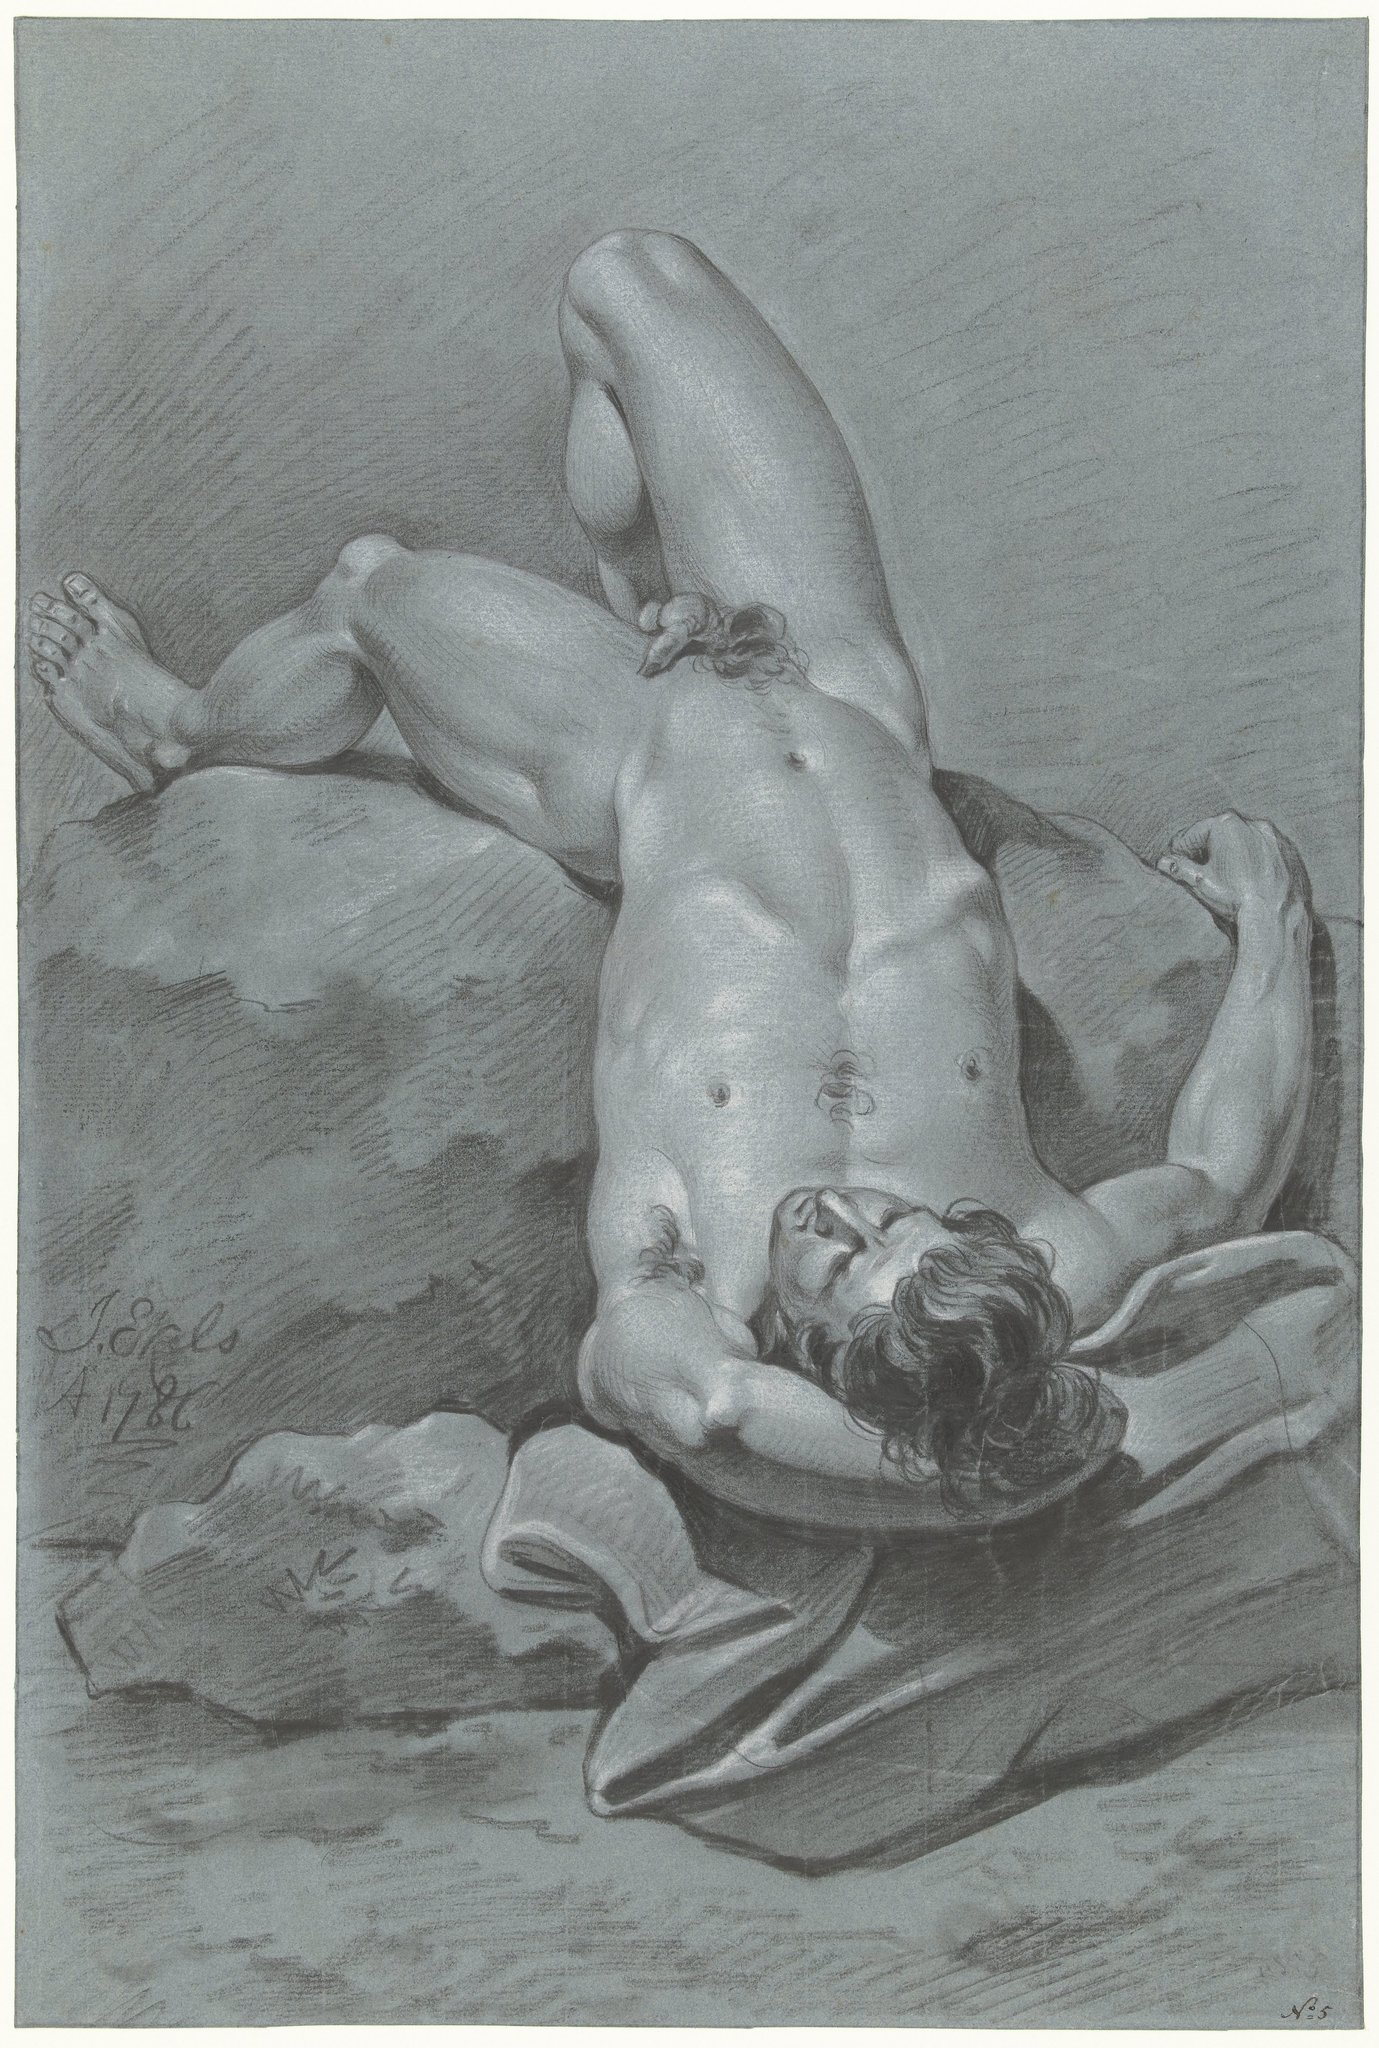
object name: drawing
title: Studie van mannelijk naakt, achterover liggend op de rug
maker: jan ekels (ii)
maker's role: draughtsman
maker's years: 1759-1793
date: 1786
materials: chalk, paper